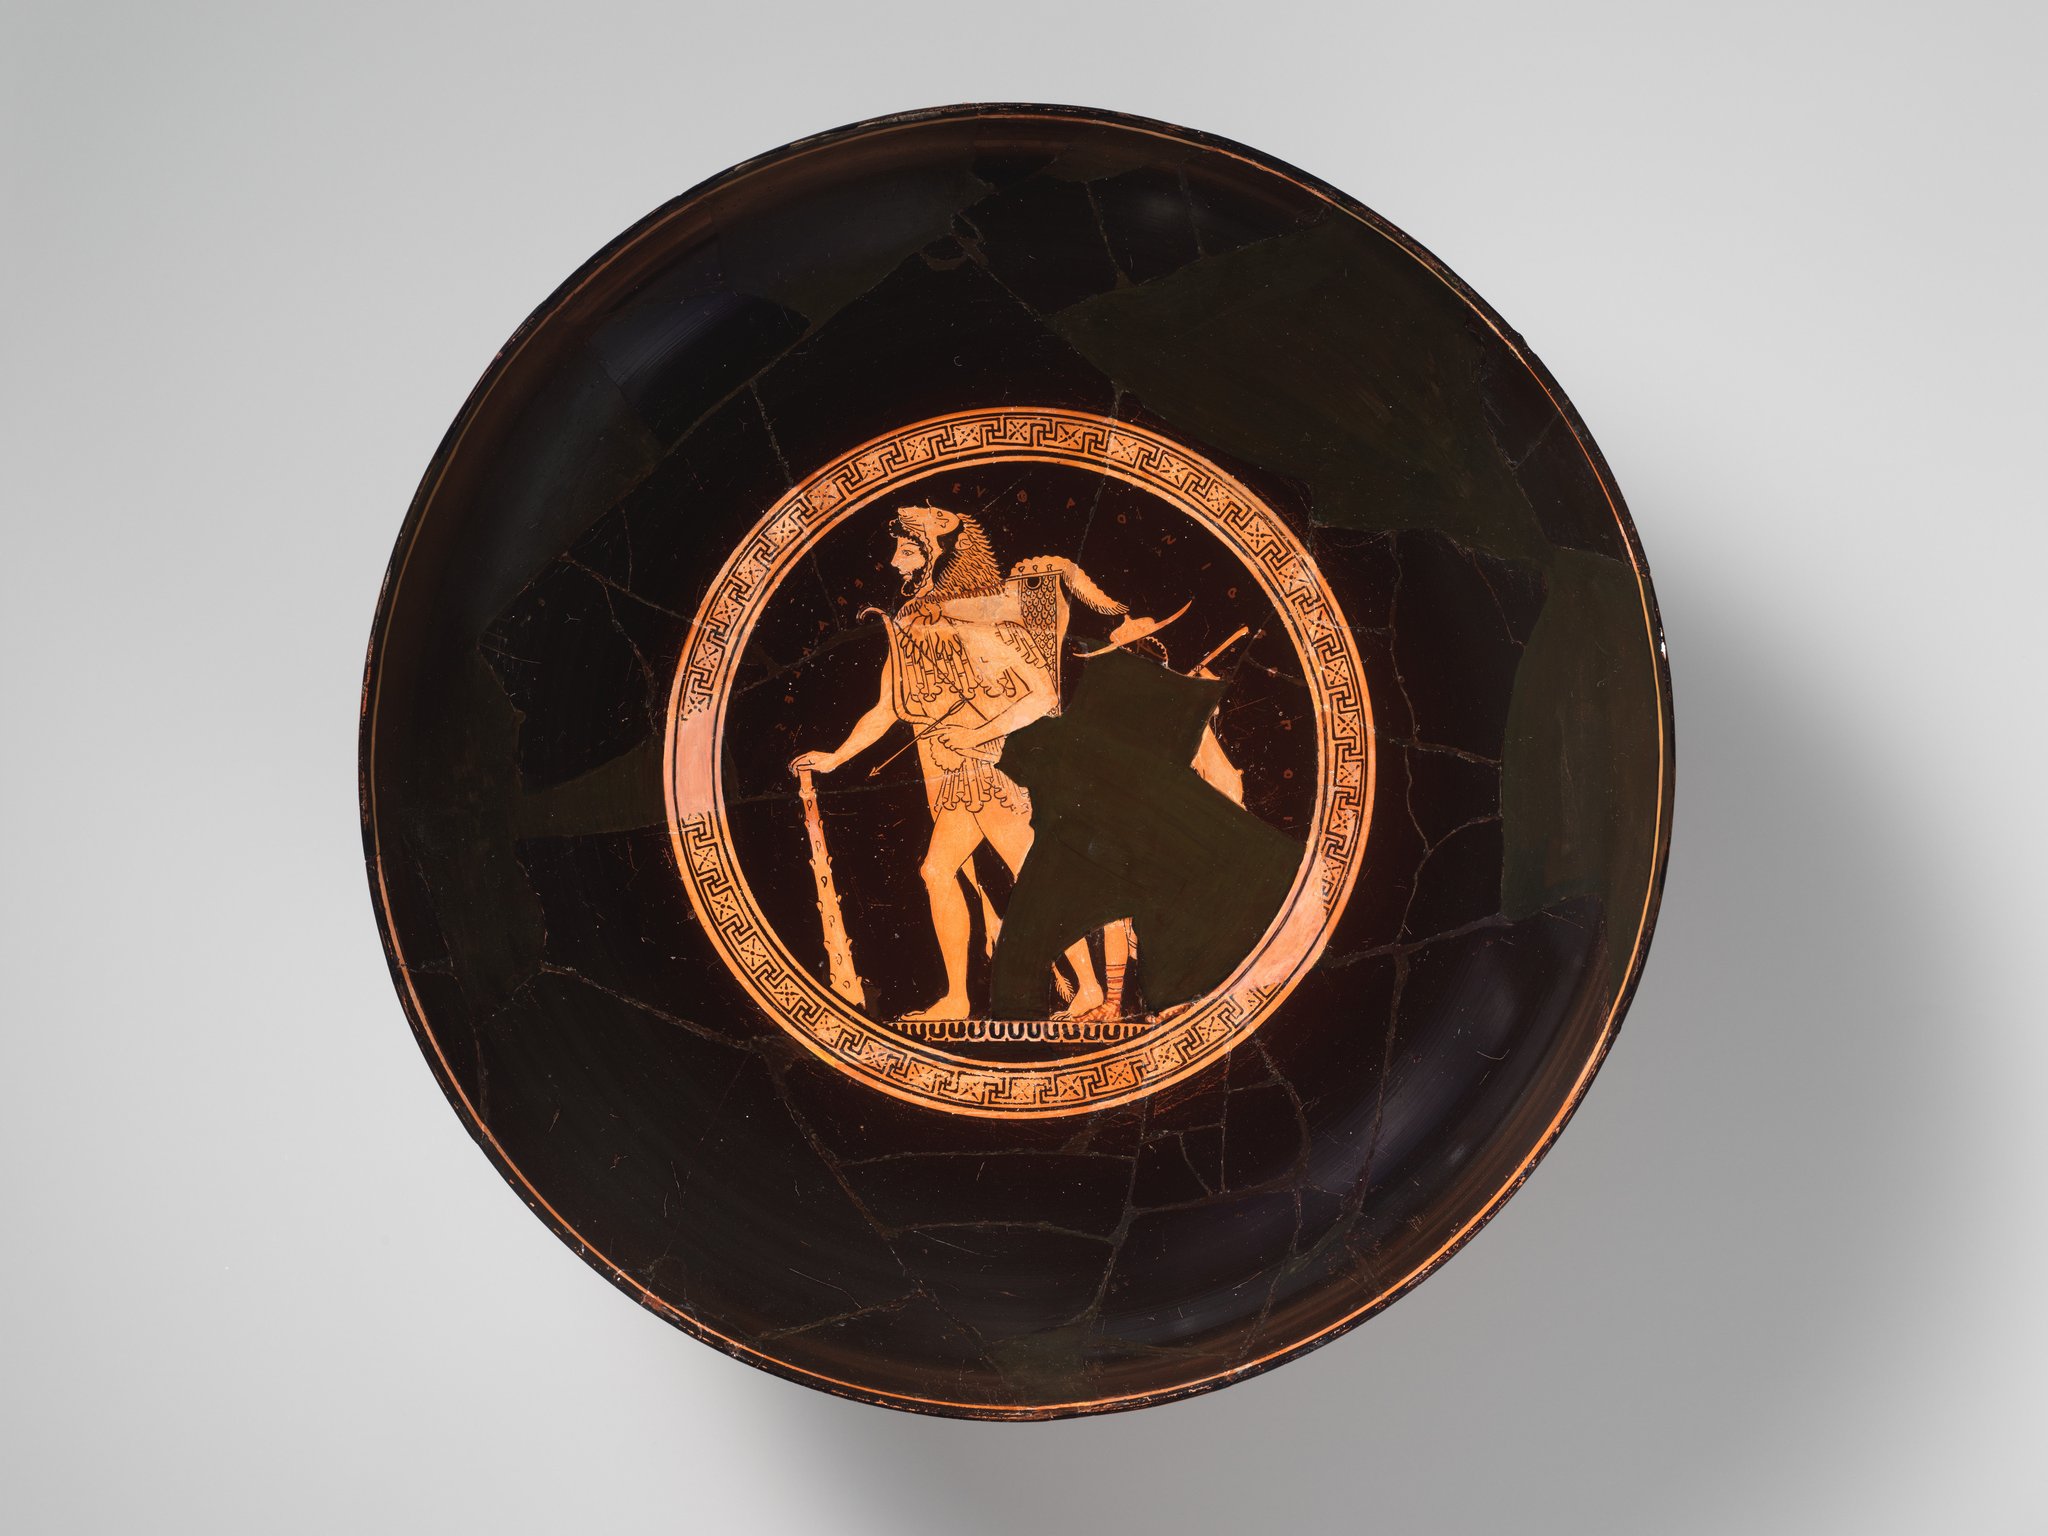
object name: kylix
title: Terracotta kylix (drinking cup)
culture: greek, attic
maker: euphronios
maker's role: artist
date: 490 BCE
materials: terracotta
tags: male nudes,herakles